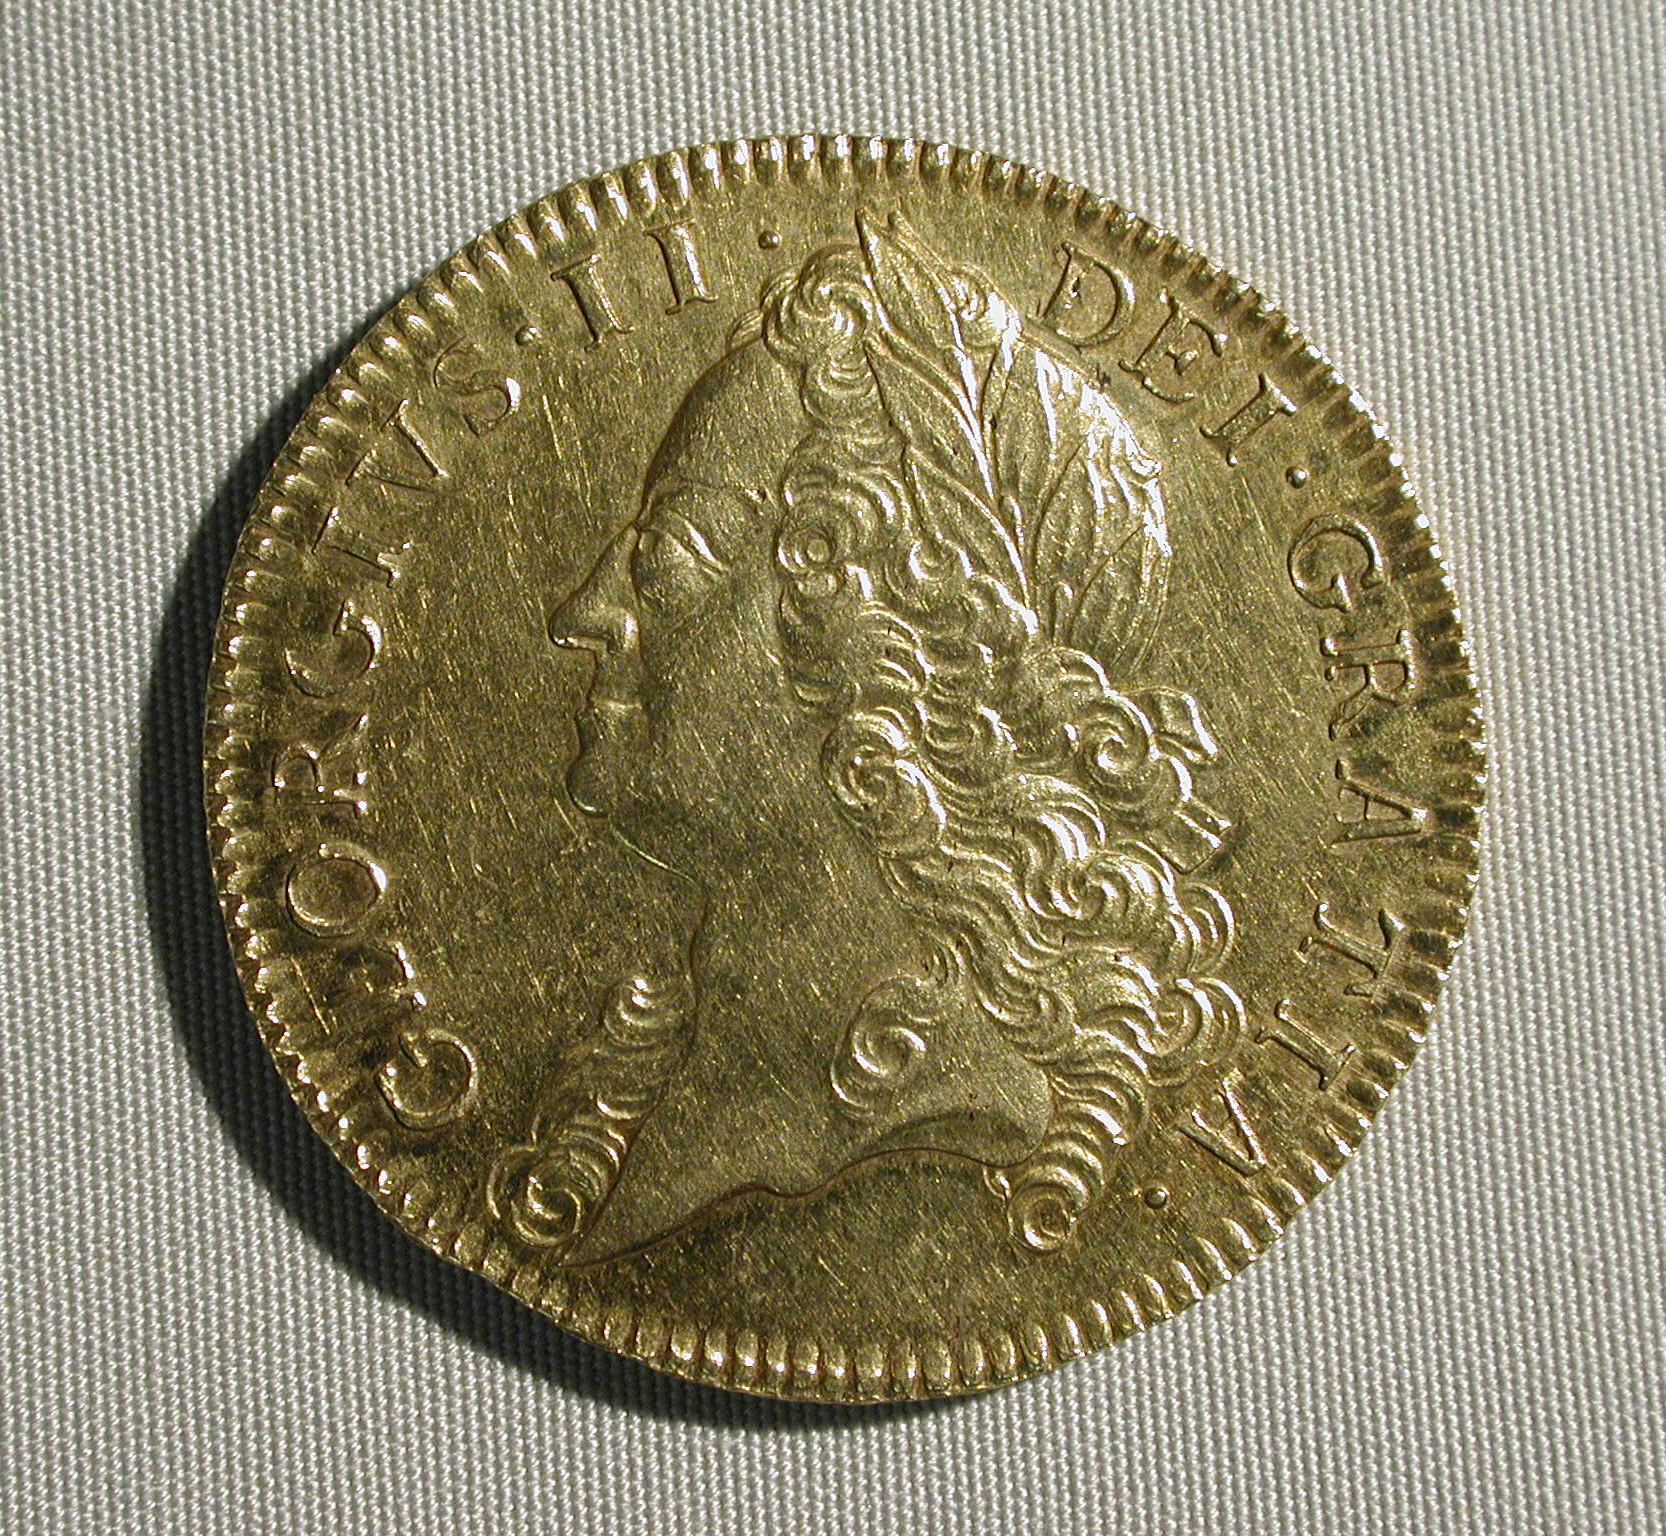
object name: guinea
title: Five guineas coin of George II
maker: john croker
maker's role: artist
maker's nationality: british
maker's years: 1670-1741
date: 1753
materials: gold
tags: kings,profiles,coins,coat of arms